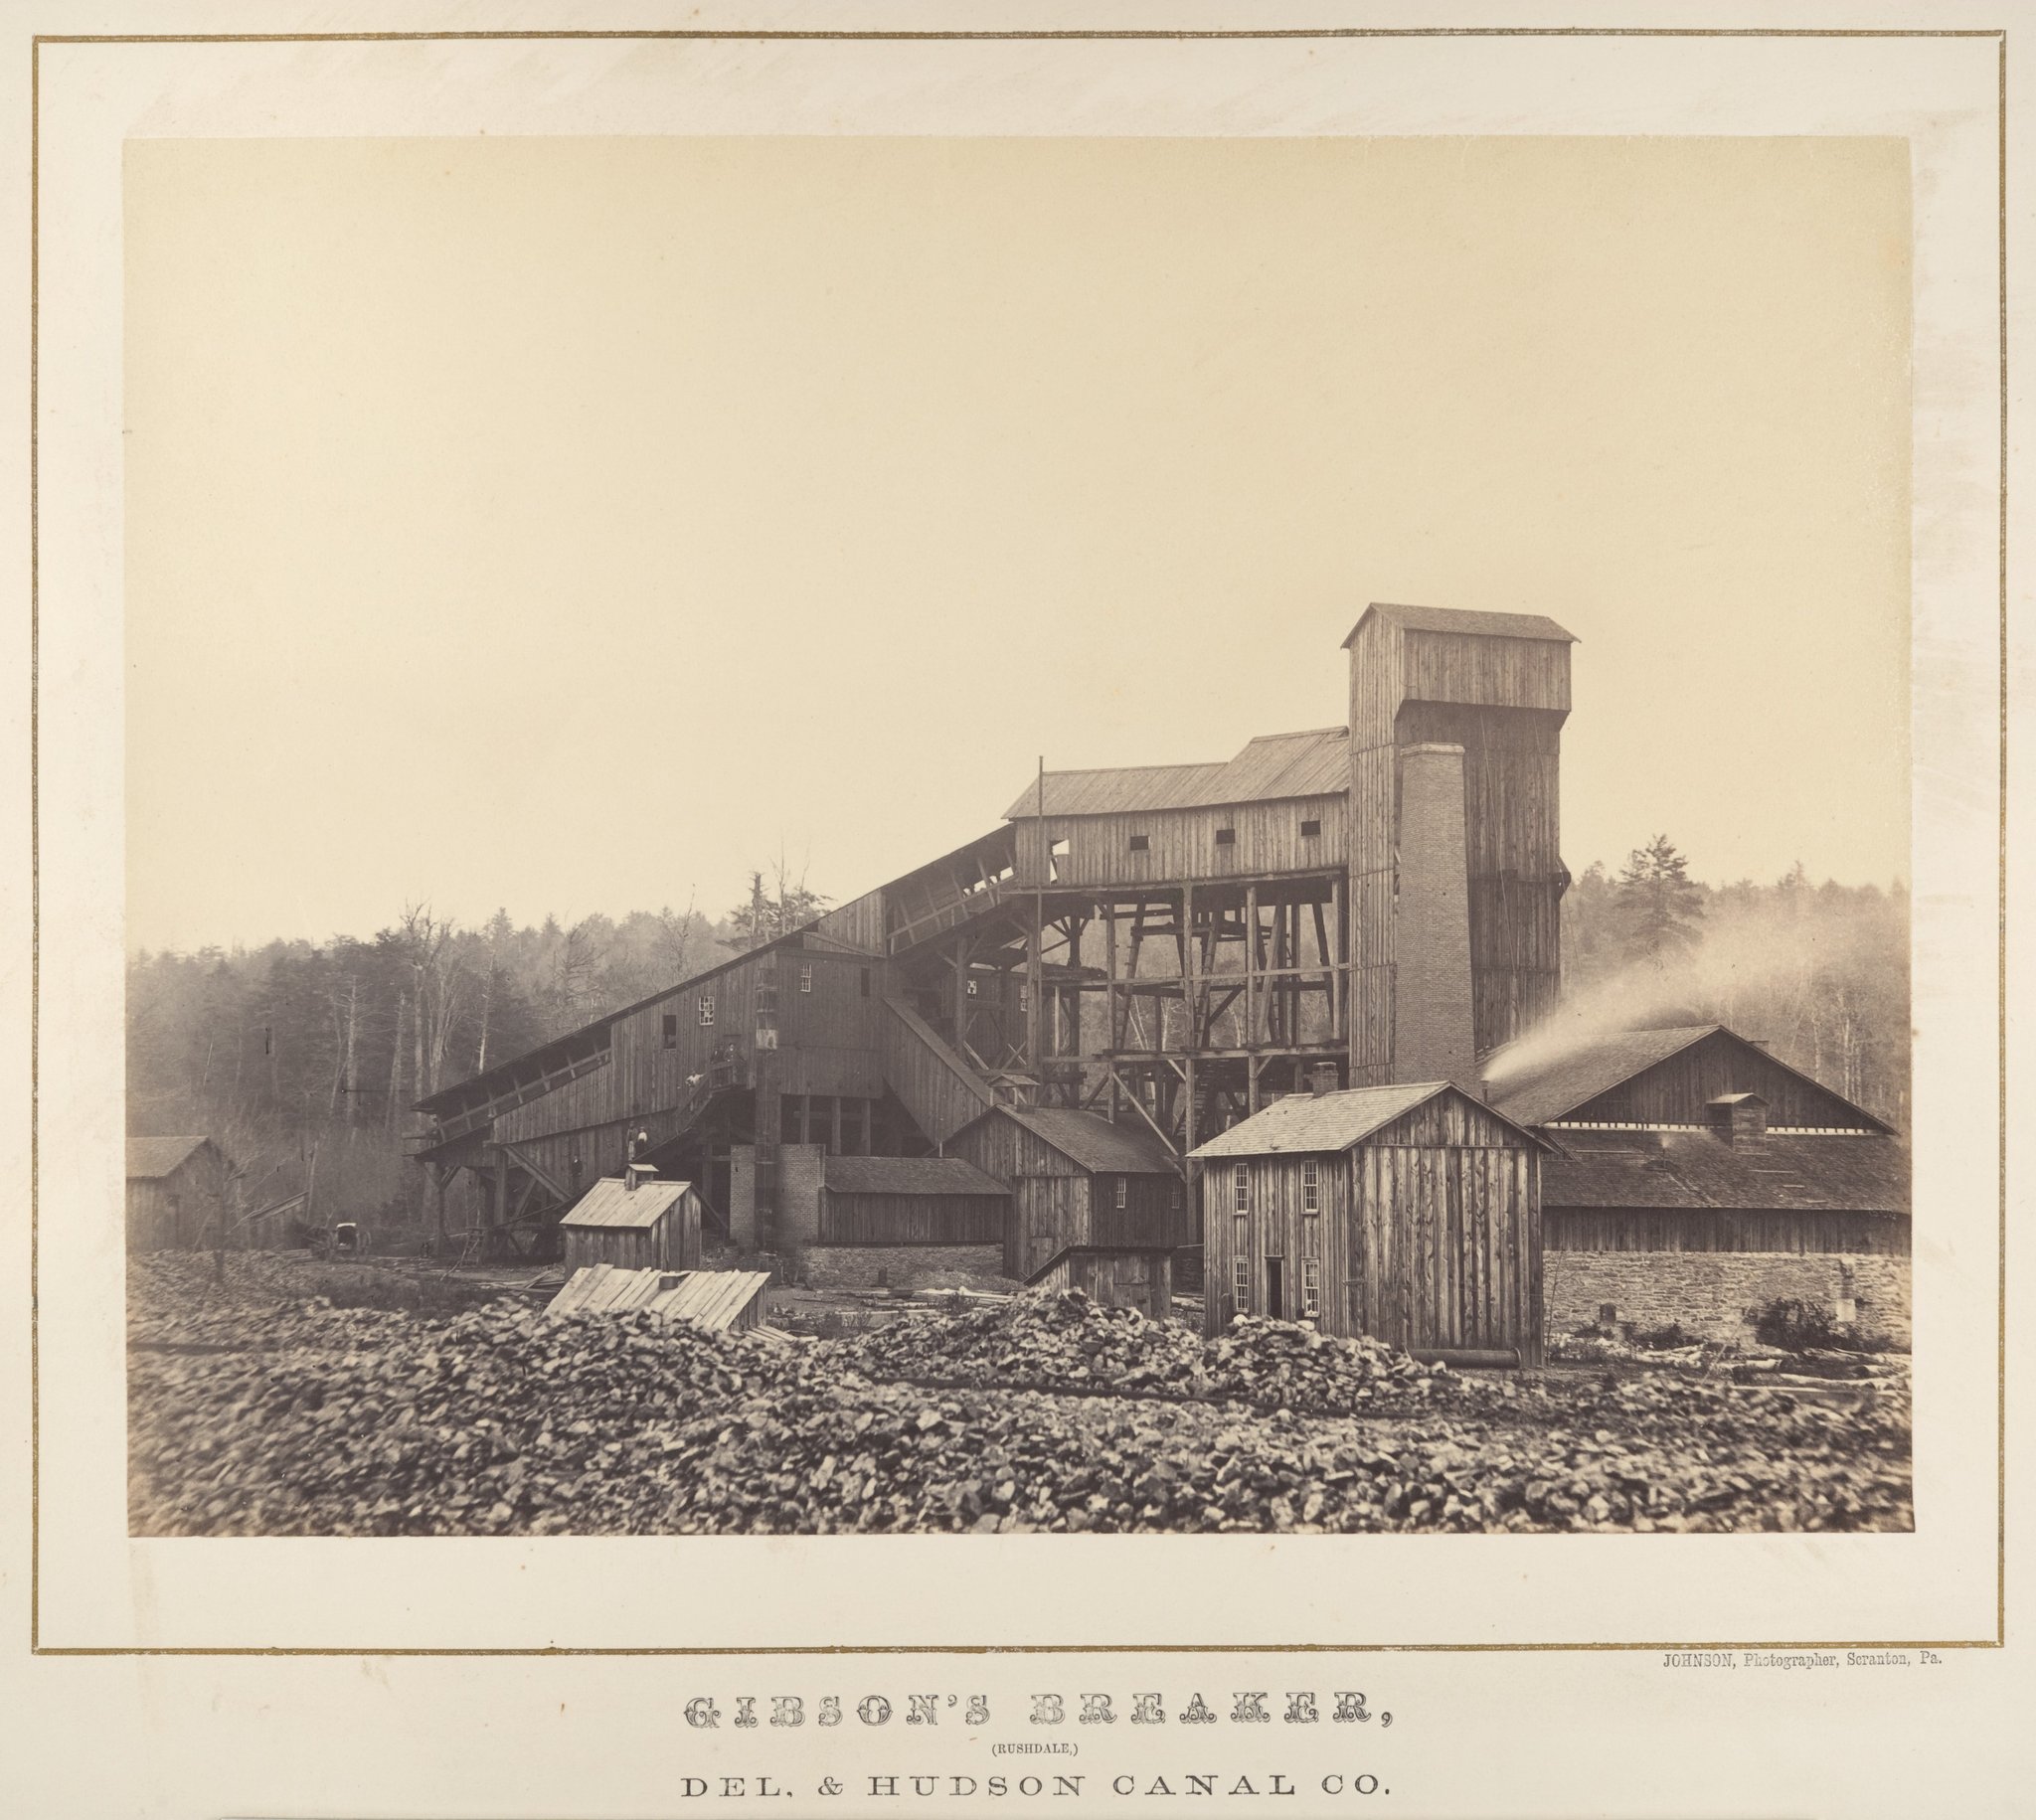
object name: photograph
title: Gibson's Breaker, Rushdale, Pennsylvania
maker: thomas h. johnson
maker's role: artist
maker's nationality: american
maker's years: 1860-1870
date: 1865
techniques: albumen silver print, glass negative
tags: architecture,factories,industry